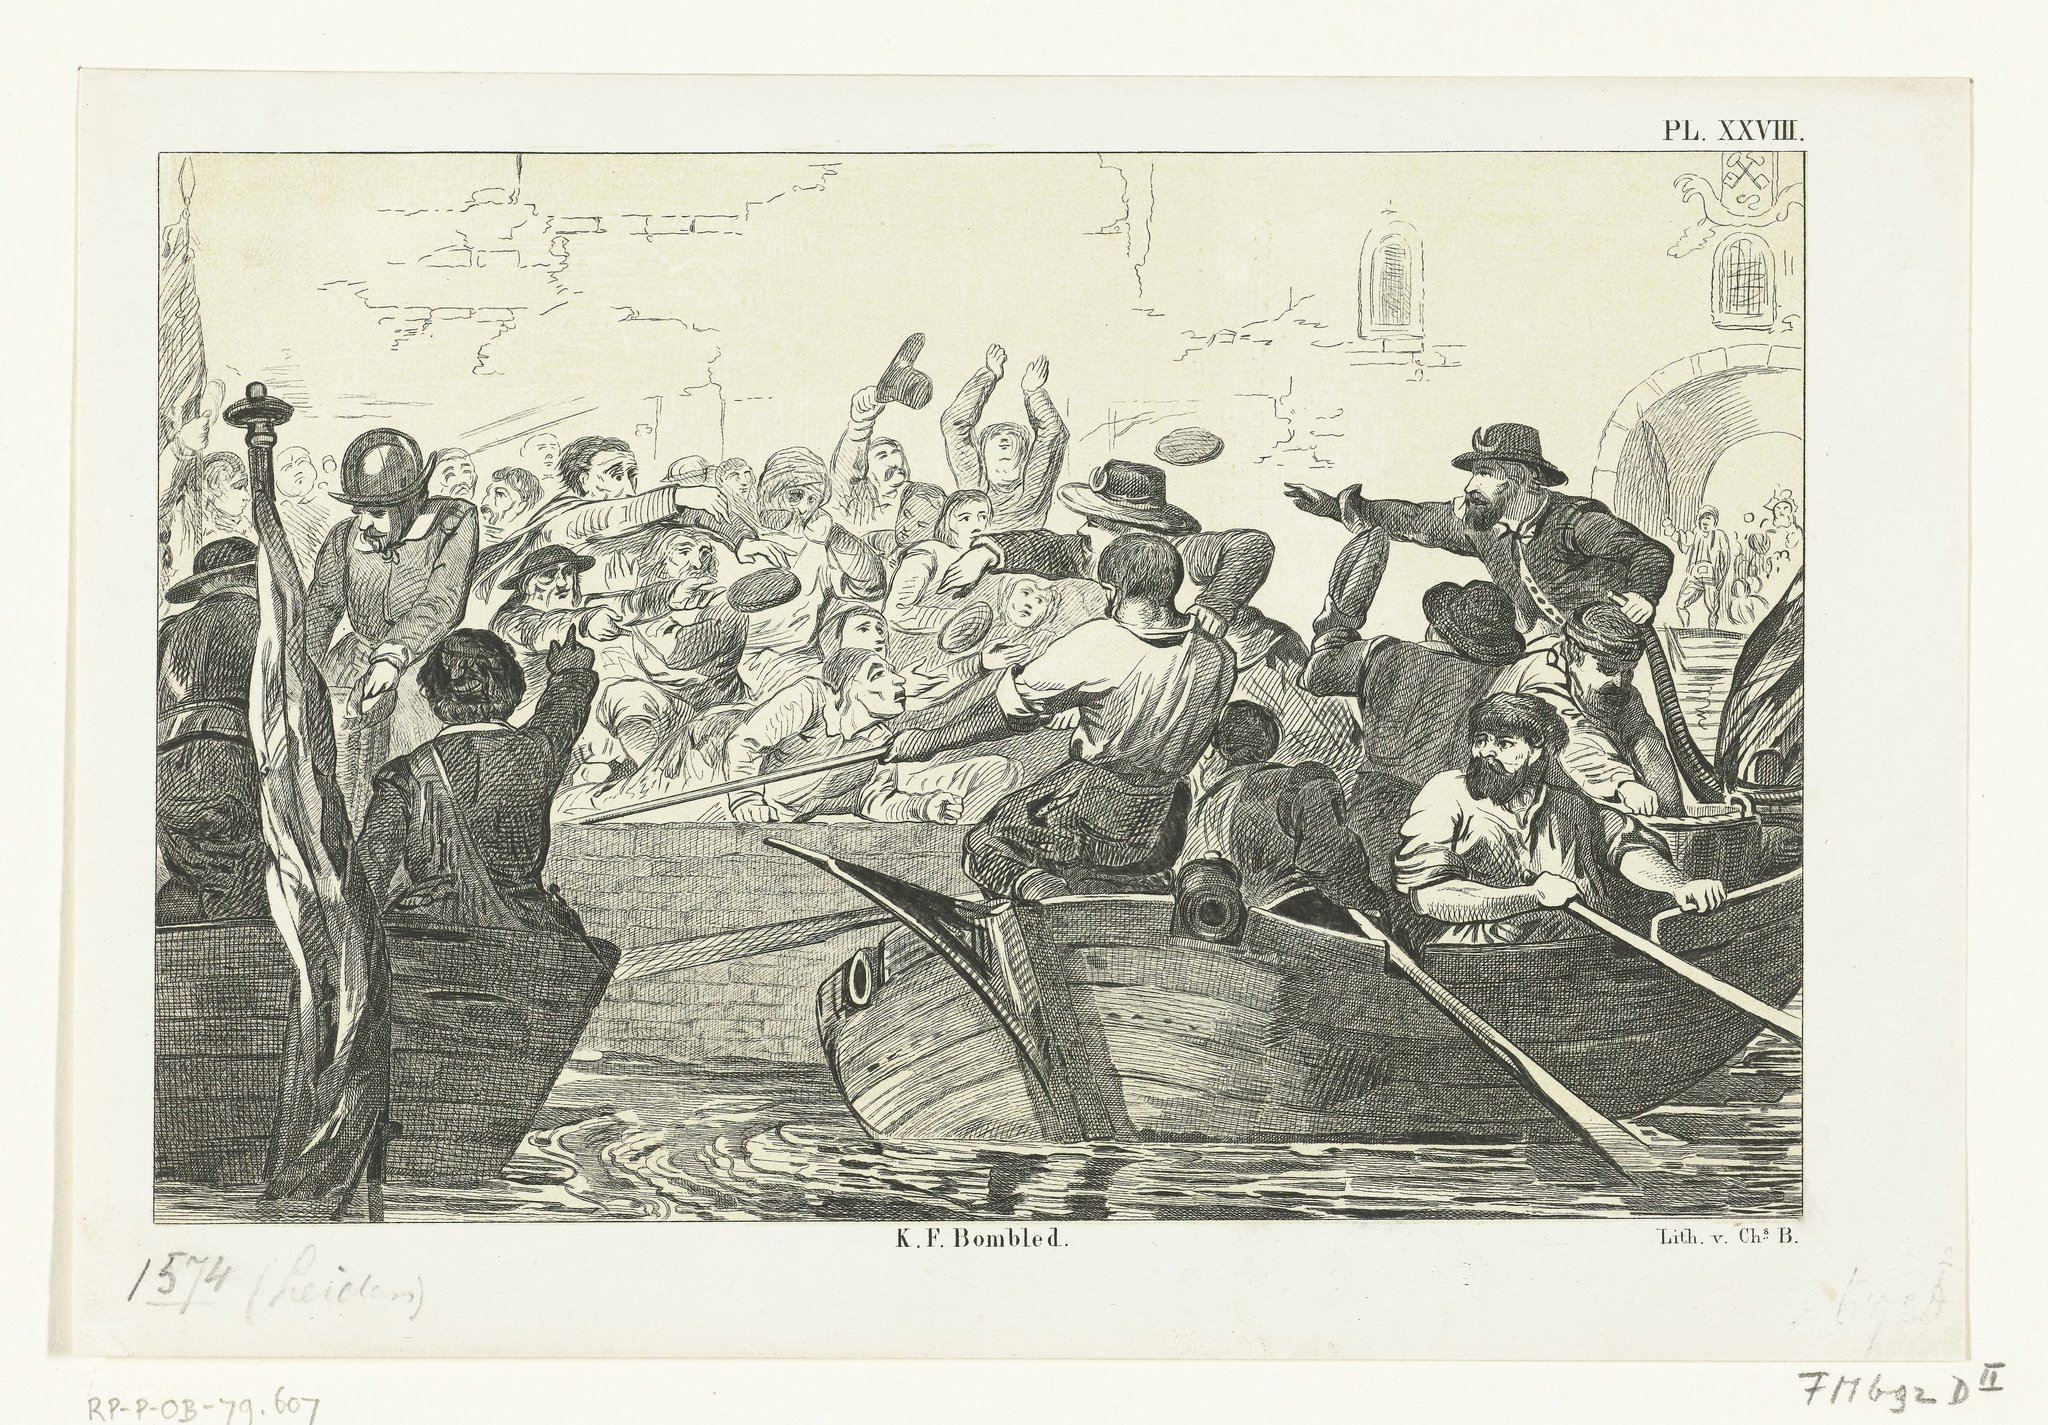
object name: print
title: Het ontzet van Leiden, 1574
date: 1853-1861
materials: paper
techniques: tone lithography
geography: netherlands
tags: raising the siege with outside assistance, relief, leiden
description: Illustratie voor: Jacob van Lennep, De geschiedenis des vaderlands in schetsen en afbeeldingen, Binger, Amsterdam 1855-1861, 8 delen, pl. XXVIII. Niet in Frederik Muller; door het RPK toegevoegd nummer.